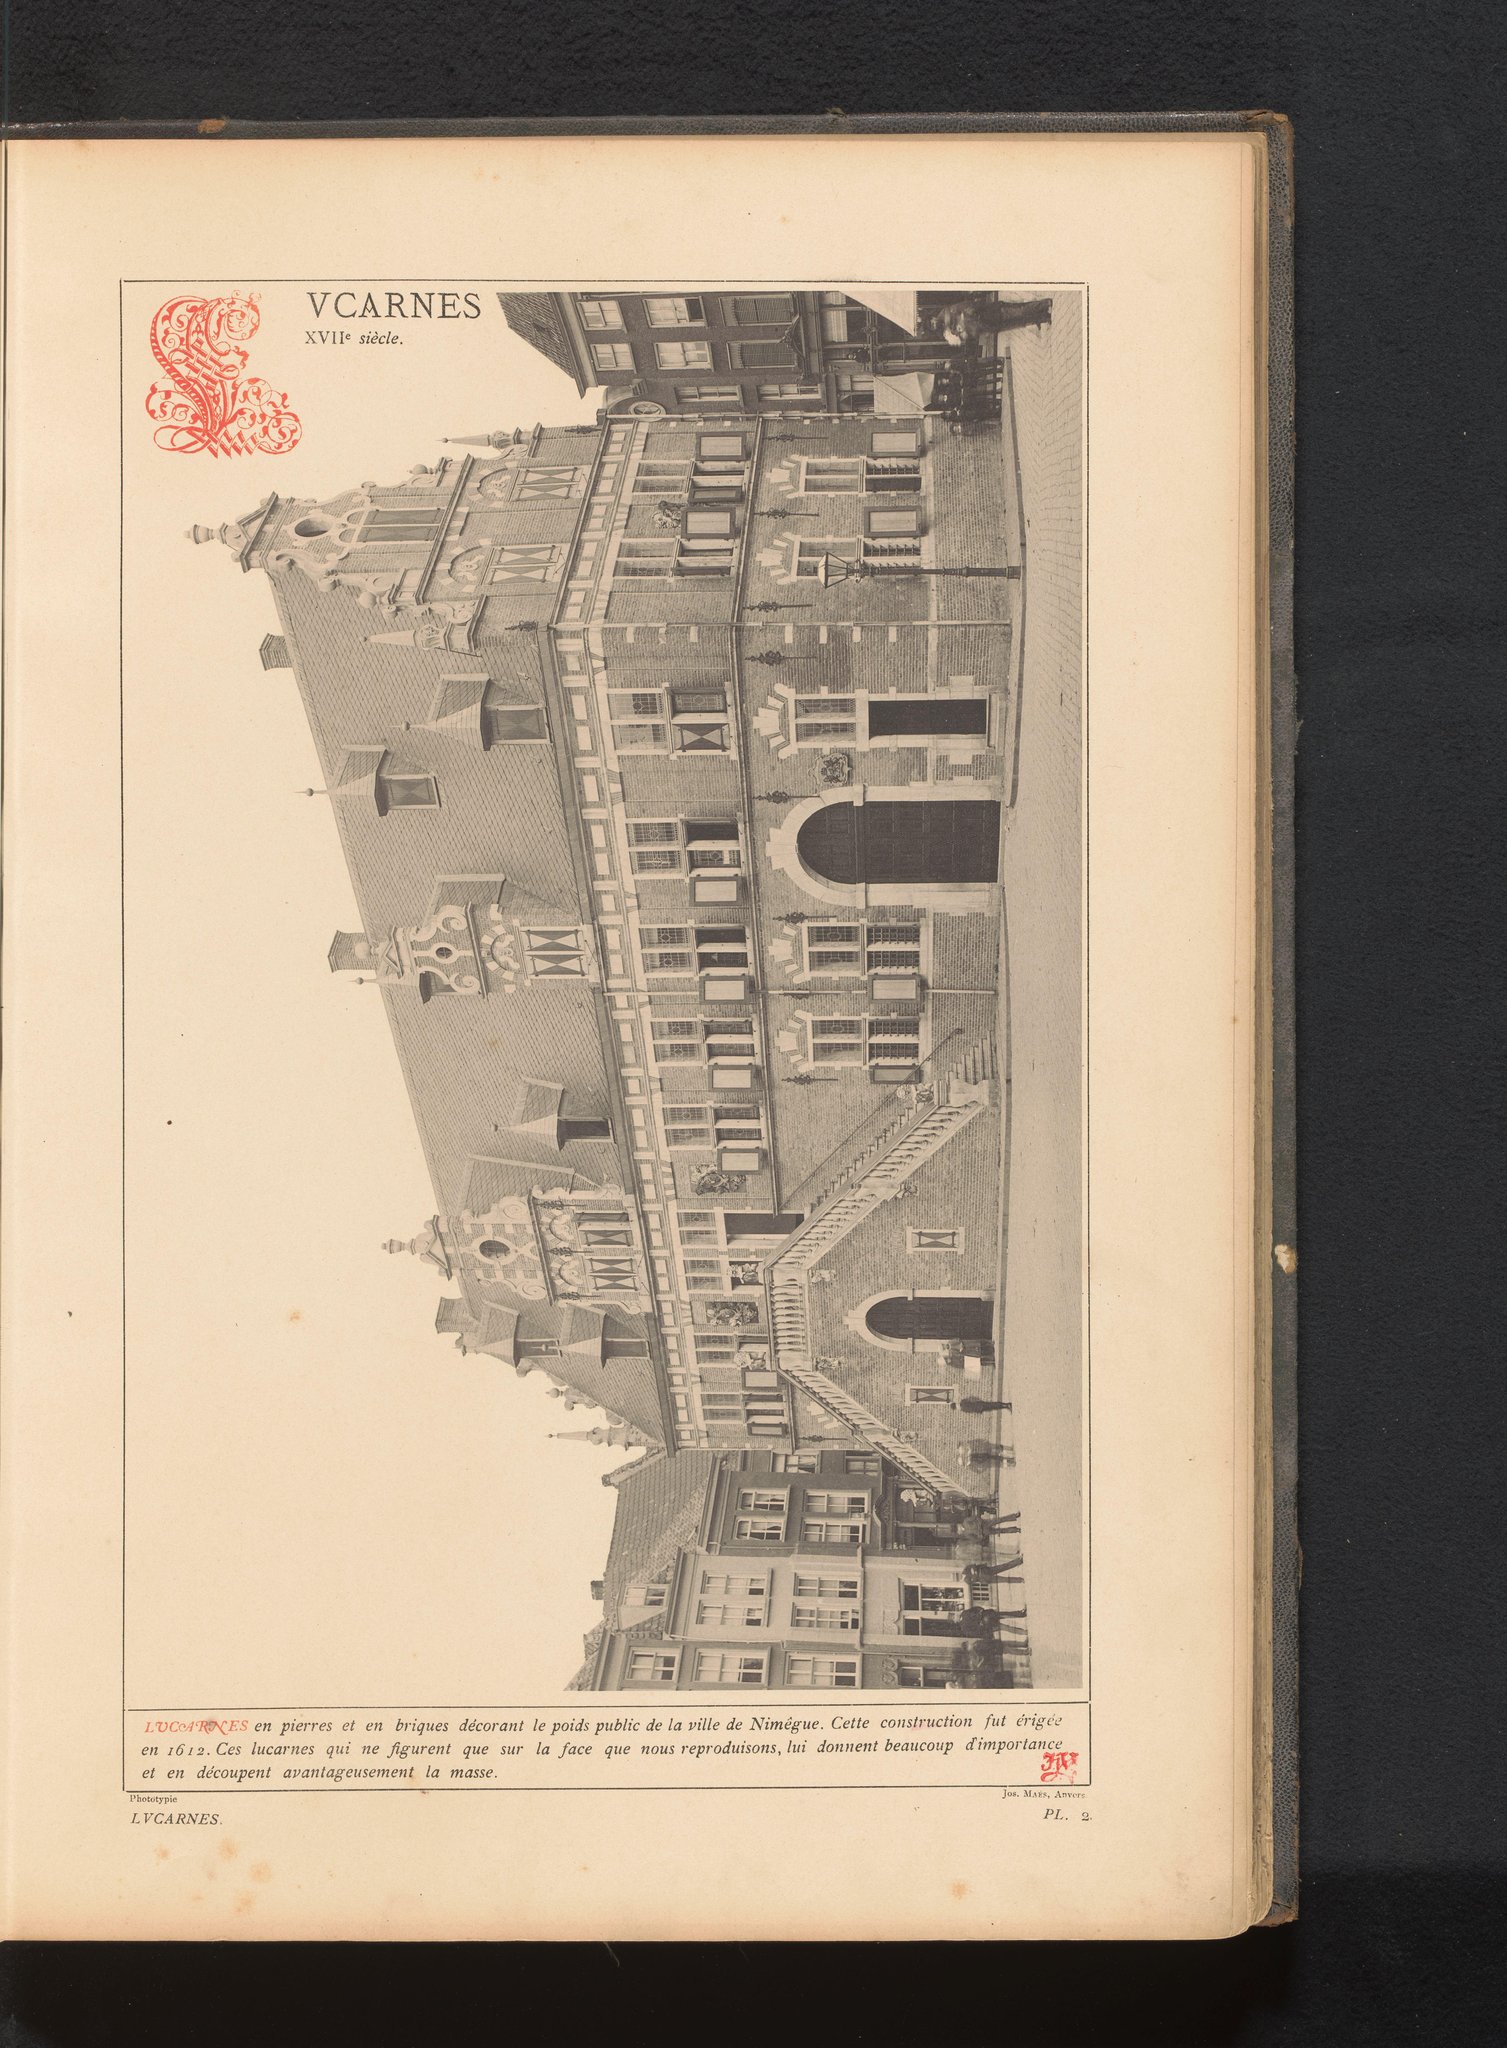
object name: page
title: Lucarnes, XVIIe Siècle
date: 1881-1889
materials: paper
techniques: photograph, photolithography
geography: antwerp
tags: weigh-house, nijmegen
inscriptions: inscription: ‘LUCARNES en pierres (...)’, inscription: ‘LUCARNES. PL. 2.’, monogram: ‘JJvY’